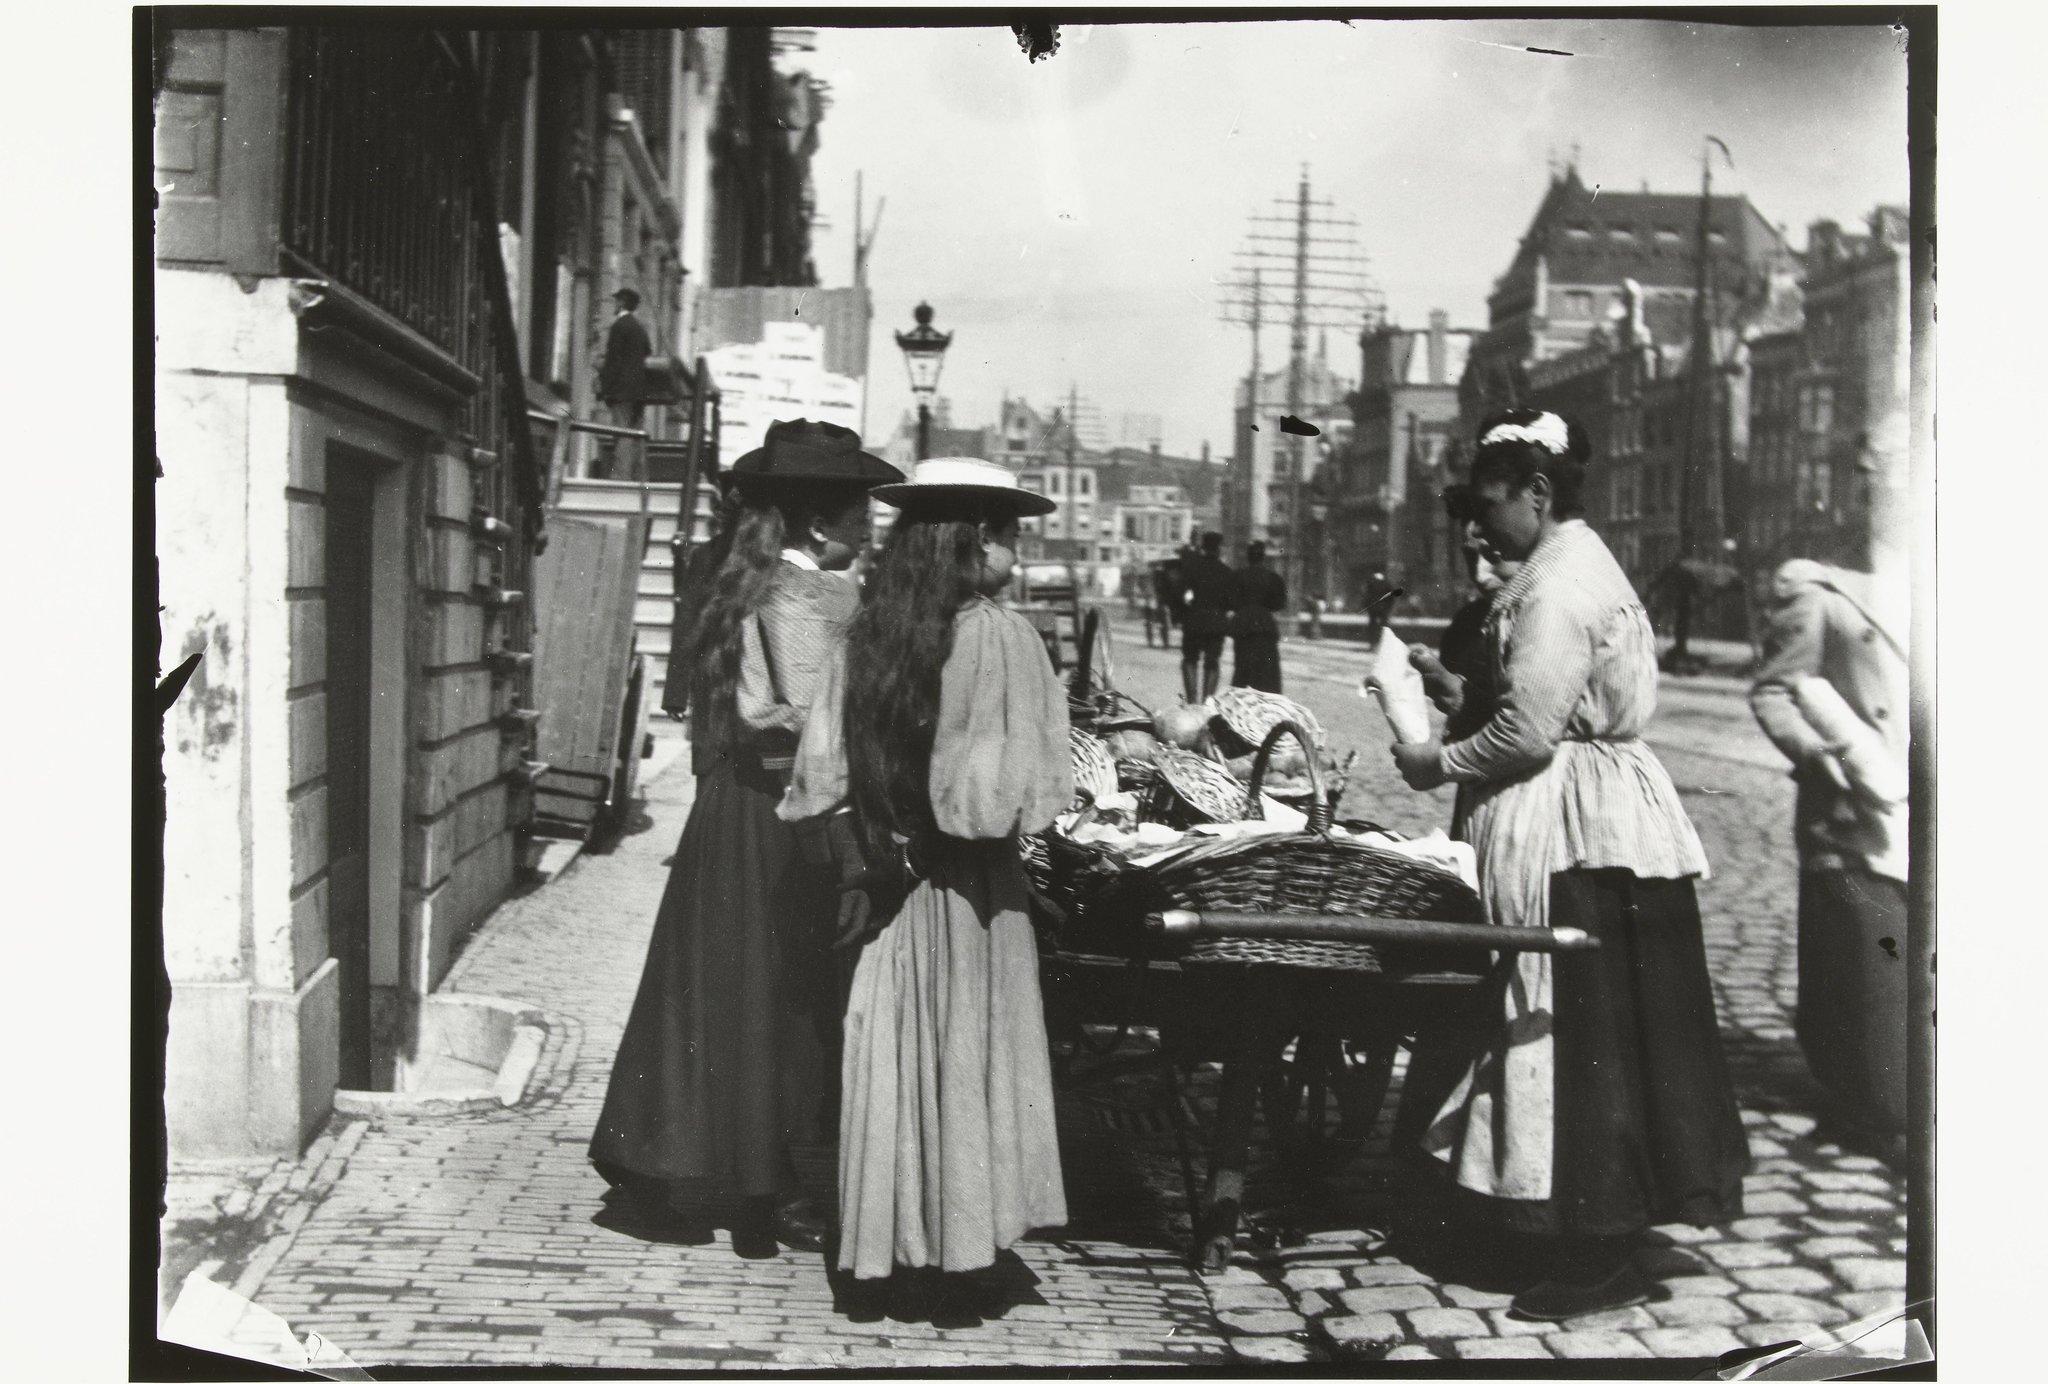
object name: photograph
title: Straatverkoop vanuit een handkar op het Rokin in Amsterdam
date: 1890-1910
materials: paper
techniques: gelatin silver print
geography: netherlands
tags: rokin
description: Moderne afdruk van negatief BR 1929 (collectie RKD).